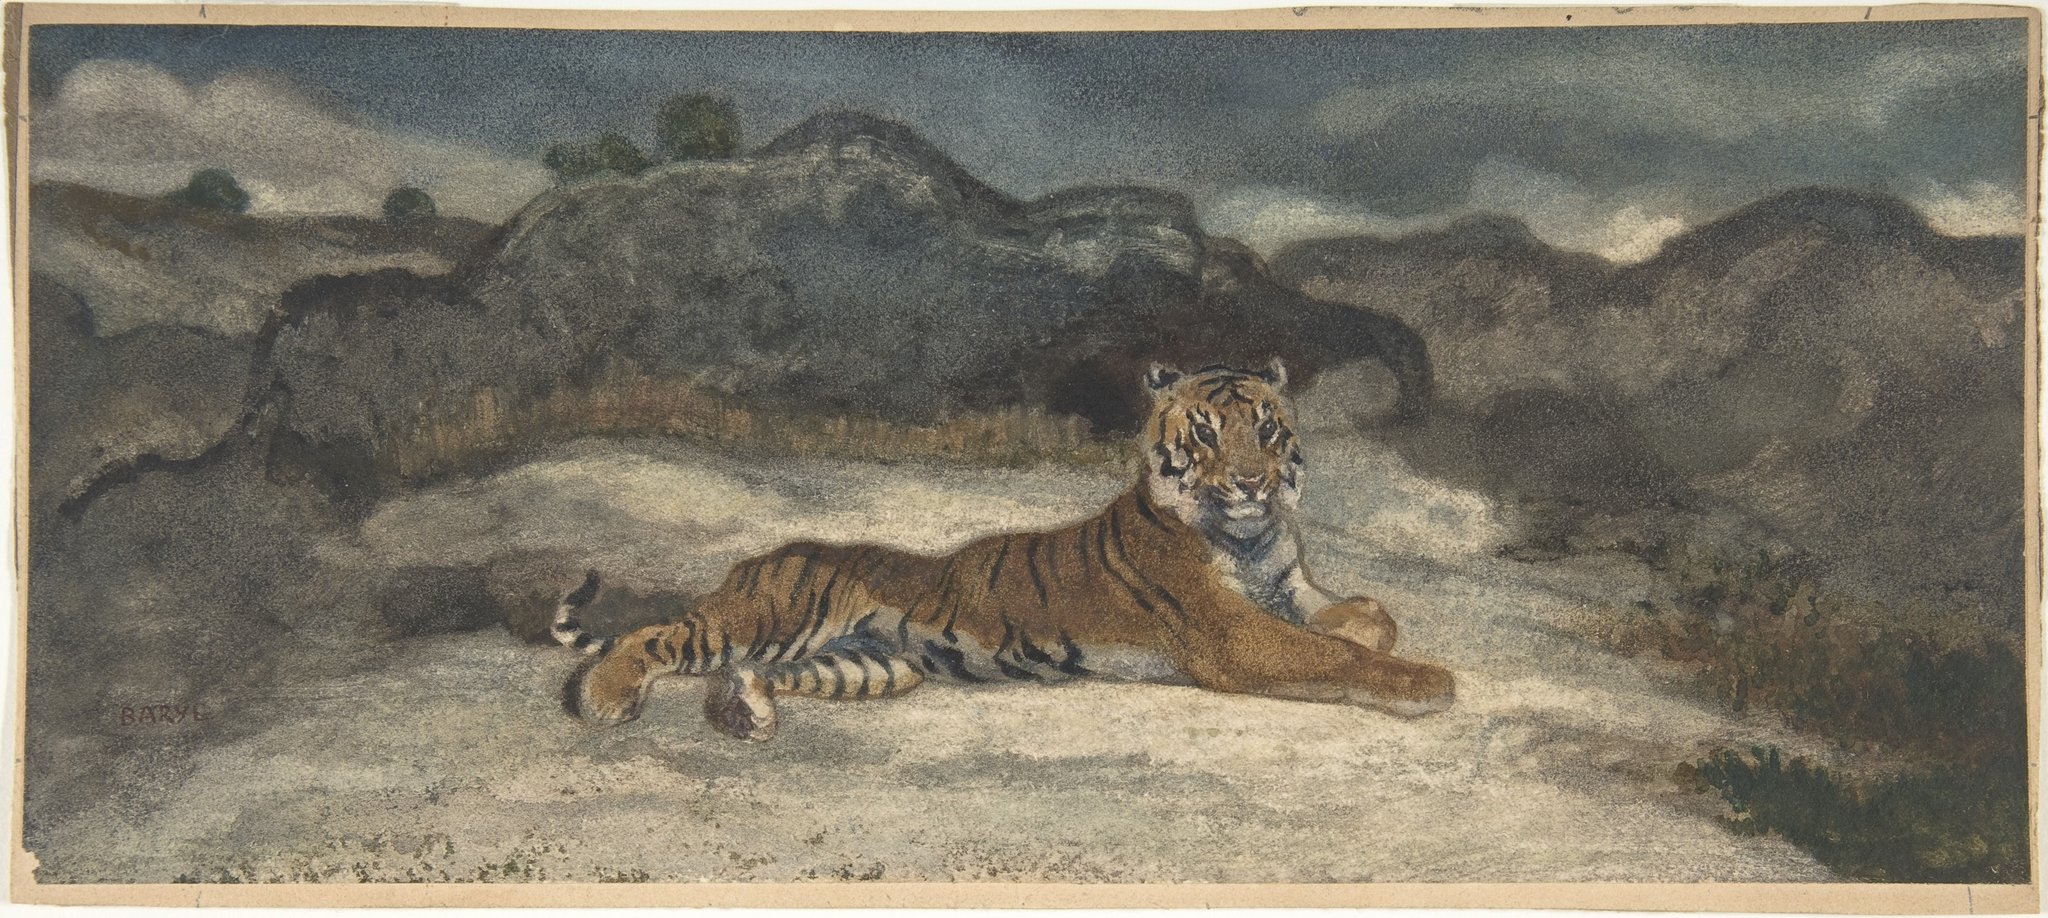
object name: drawing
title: Royal Tiger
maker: antoine-louis barye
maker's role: artist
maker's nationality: french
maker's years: 1795-1875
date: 1810-1875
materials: gouache, watercolor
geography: france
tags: tigers